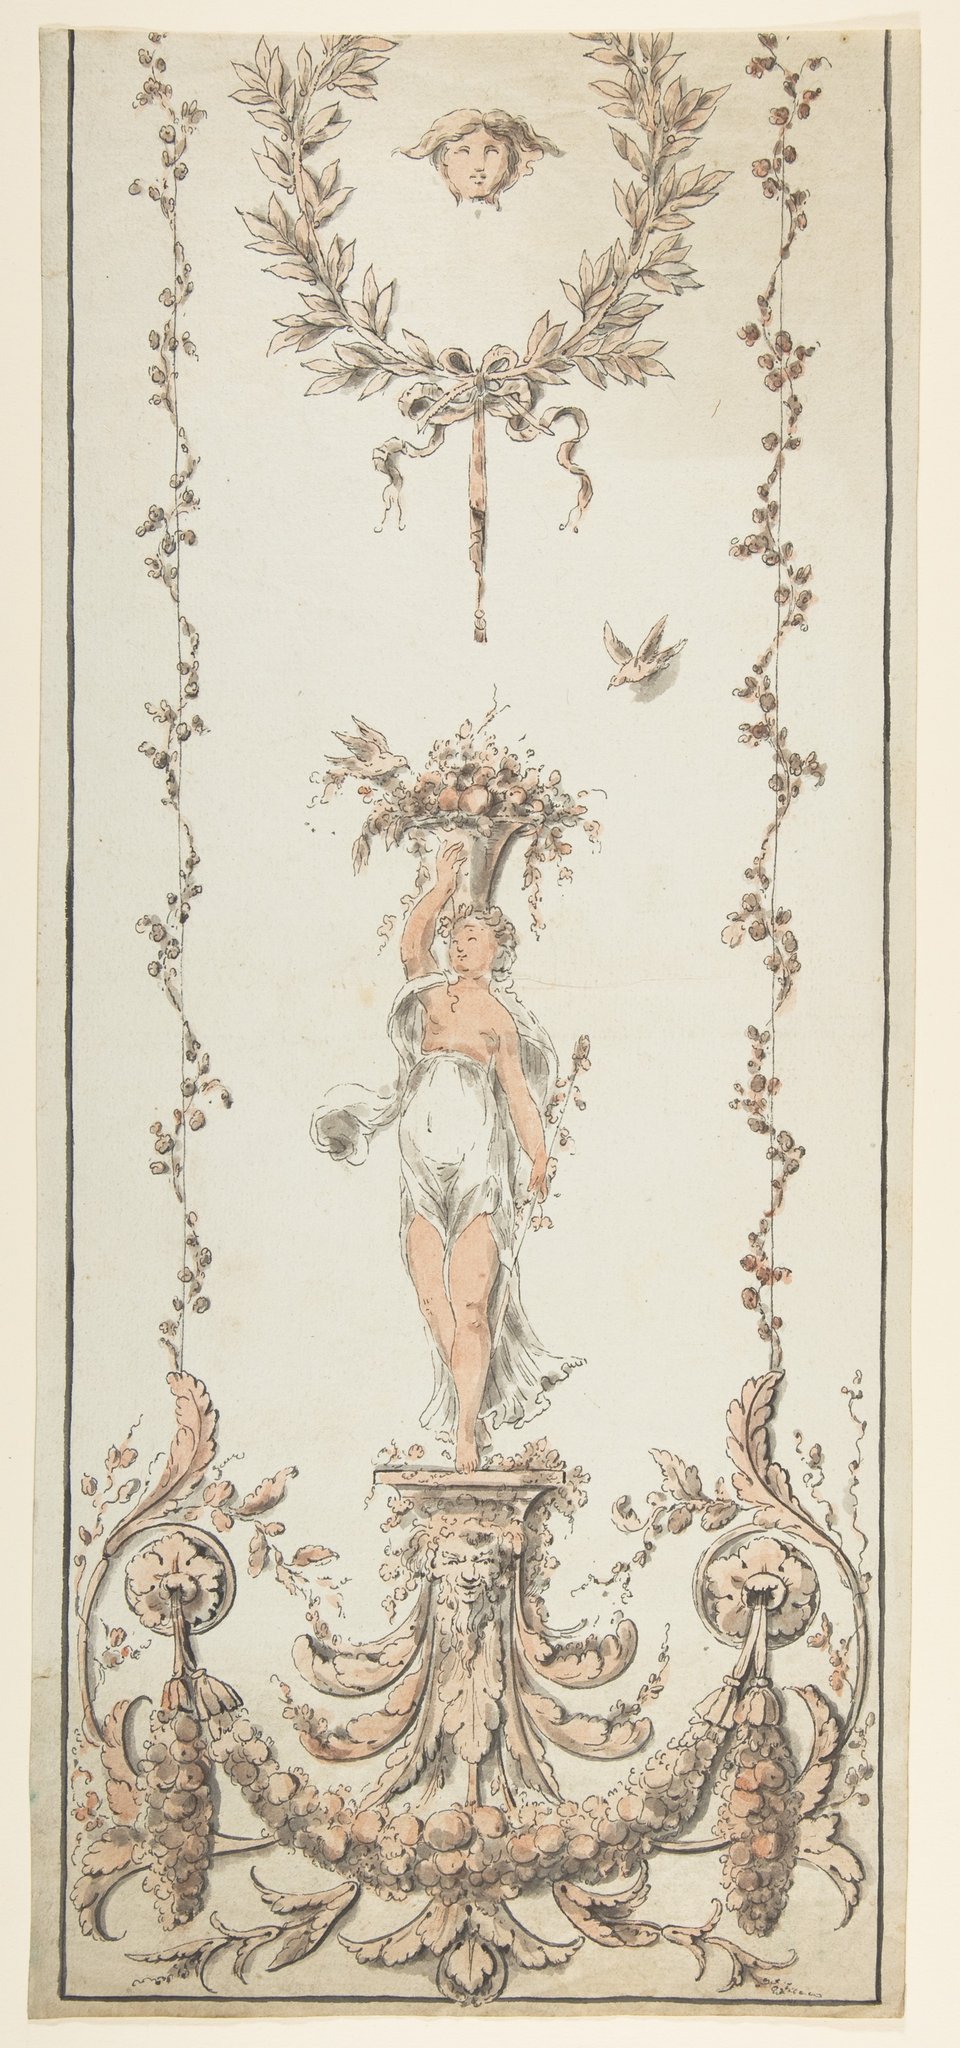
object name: drawing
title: Design for an Ornamental Panel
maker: anonymous, french, 19th century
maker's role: artist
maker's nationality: french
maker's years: 1800-1900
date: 1801-1900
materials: ink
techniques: brush, pen, wash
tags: garlands,ornament,faces,men